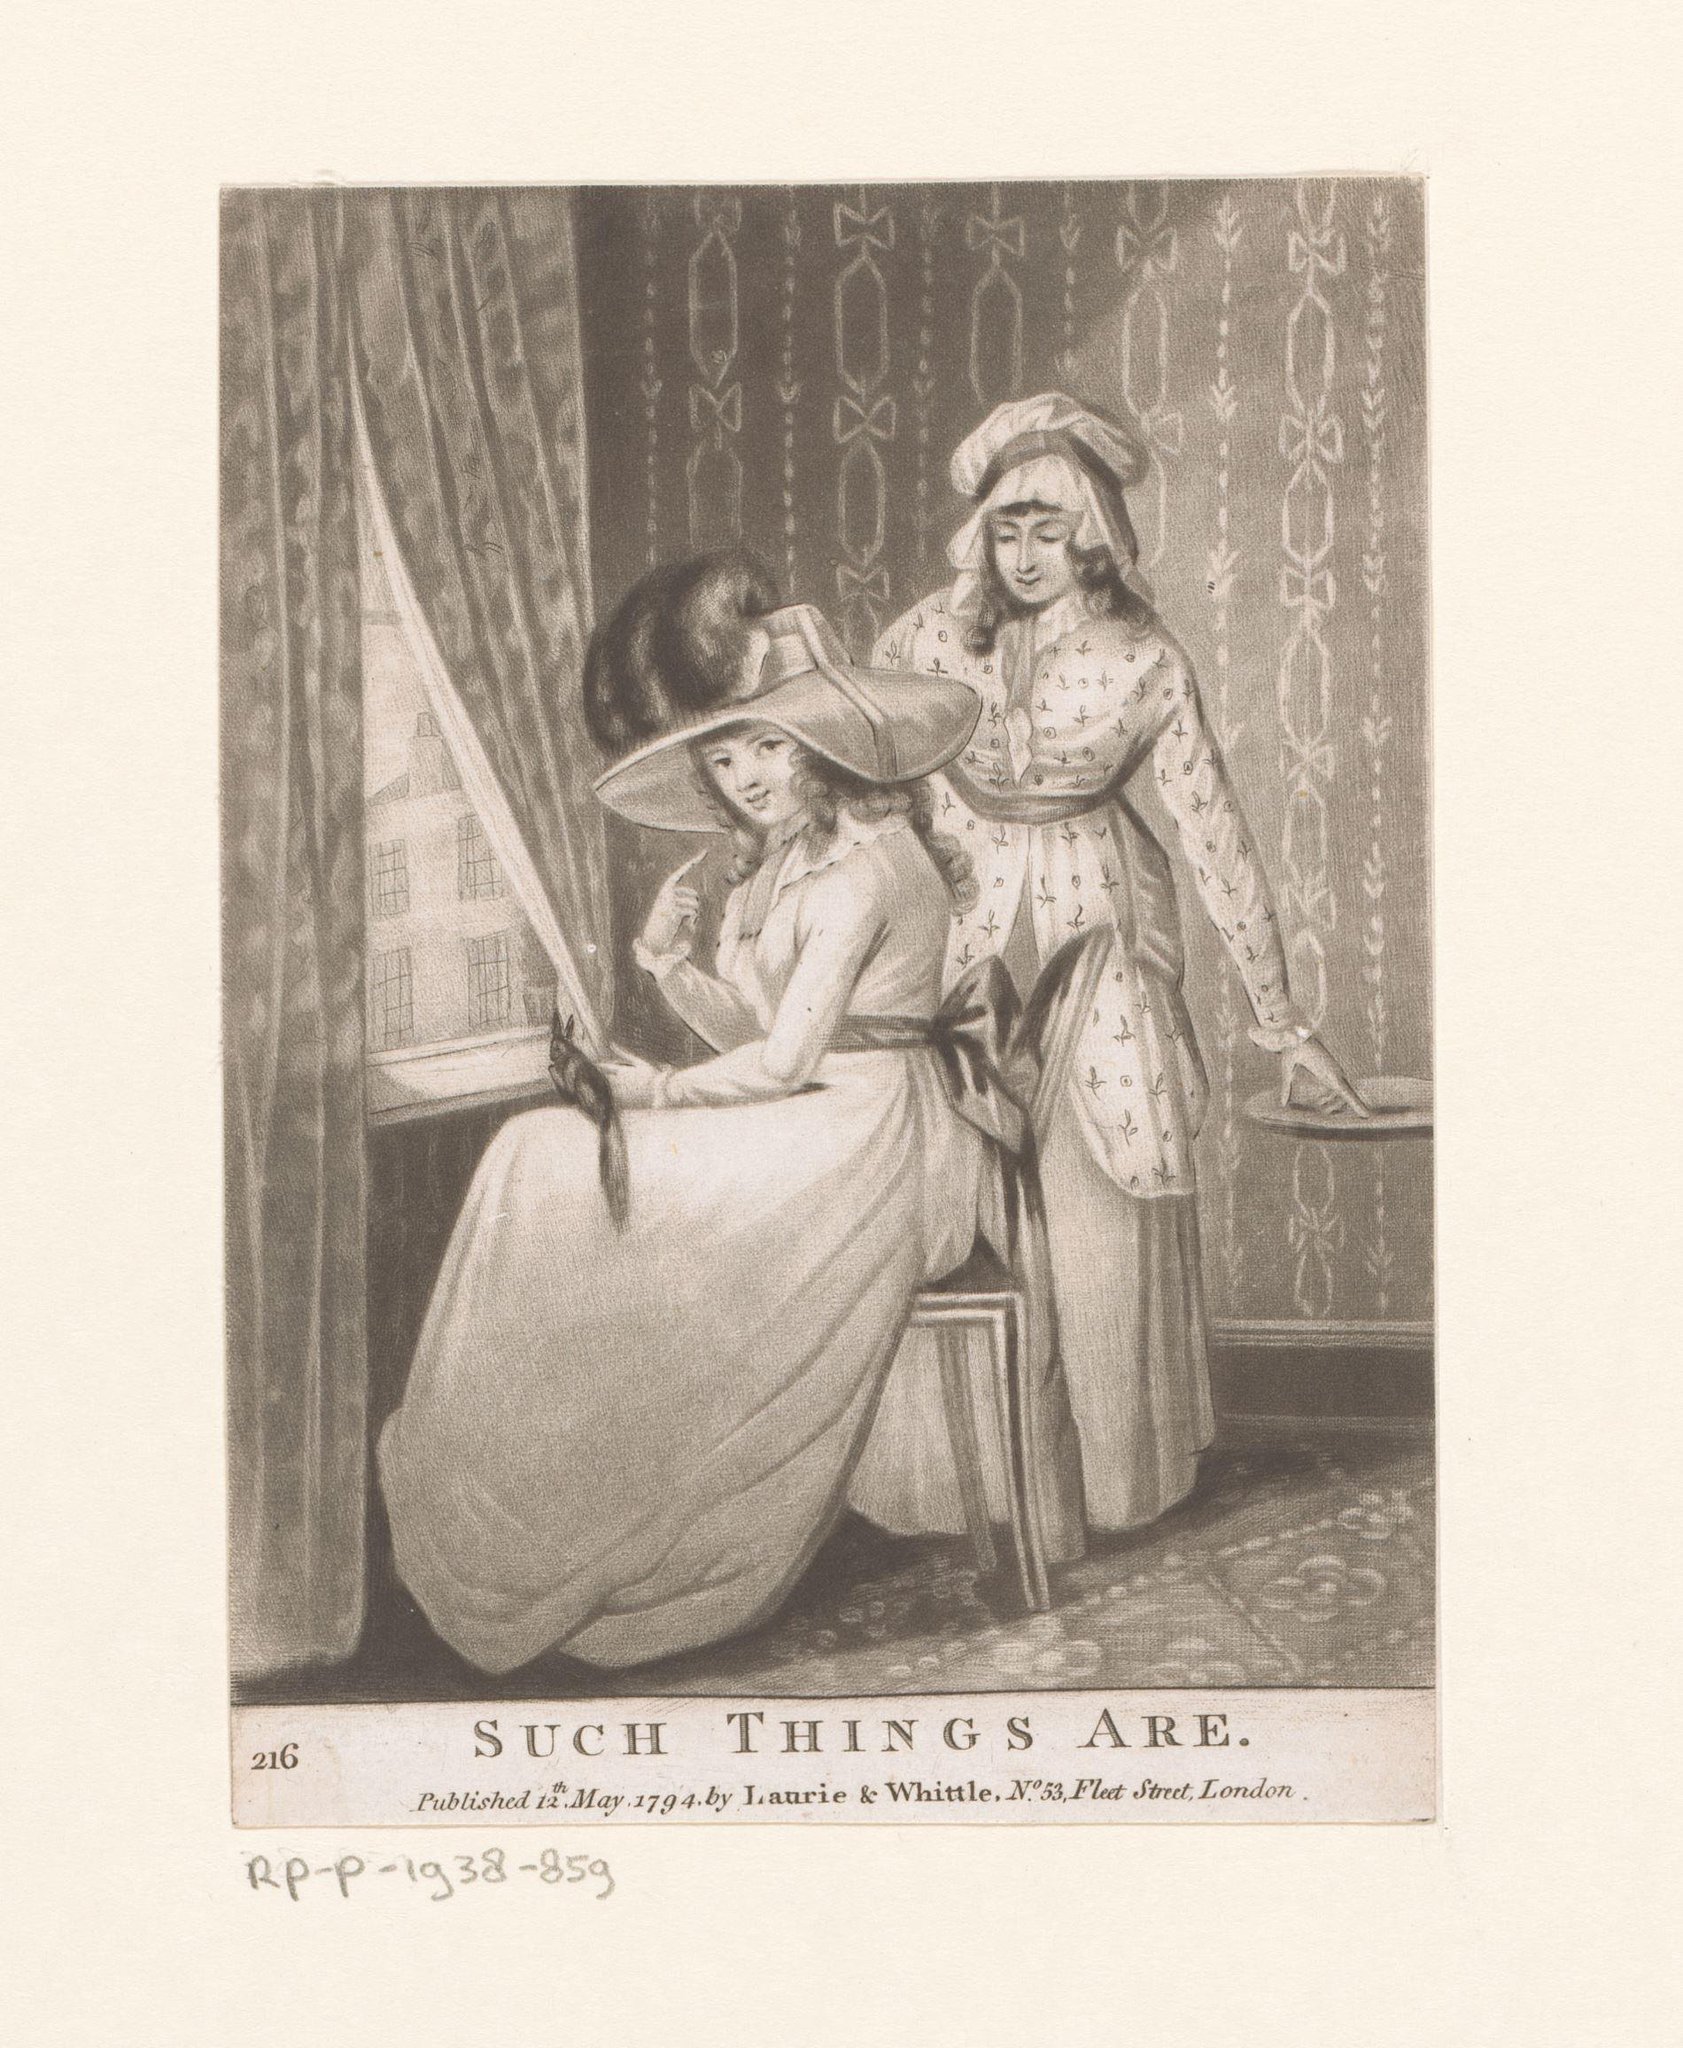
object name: cartoon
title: Such things are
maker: Anonymous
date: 1705-1794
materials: paper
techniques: mezzotint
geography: london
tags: view through a window, smiling, human figure at (open) window, seen from inside, rodents: squirrel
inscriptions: collector's mark: Lugt 2228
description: De vrouw links zit op een stoel met een eekhoorn op haar knie. Ze schuift het gordijn opzij, glimlacht en wijst naar haar gezicht. Achter haar staat een tweede vrouw, die ook lacht.